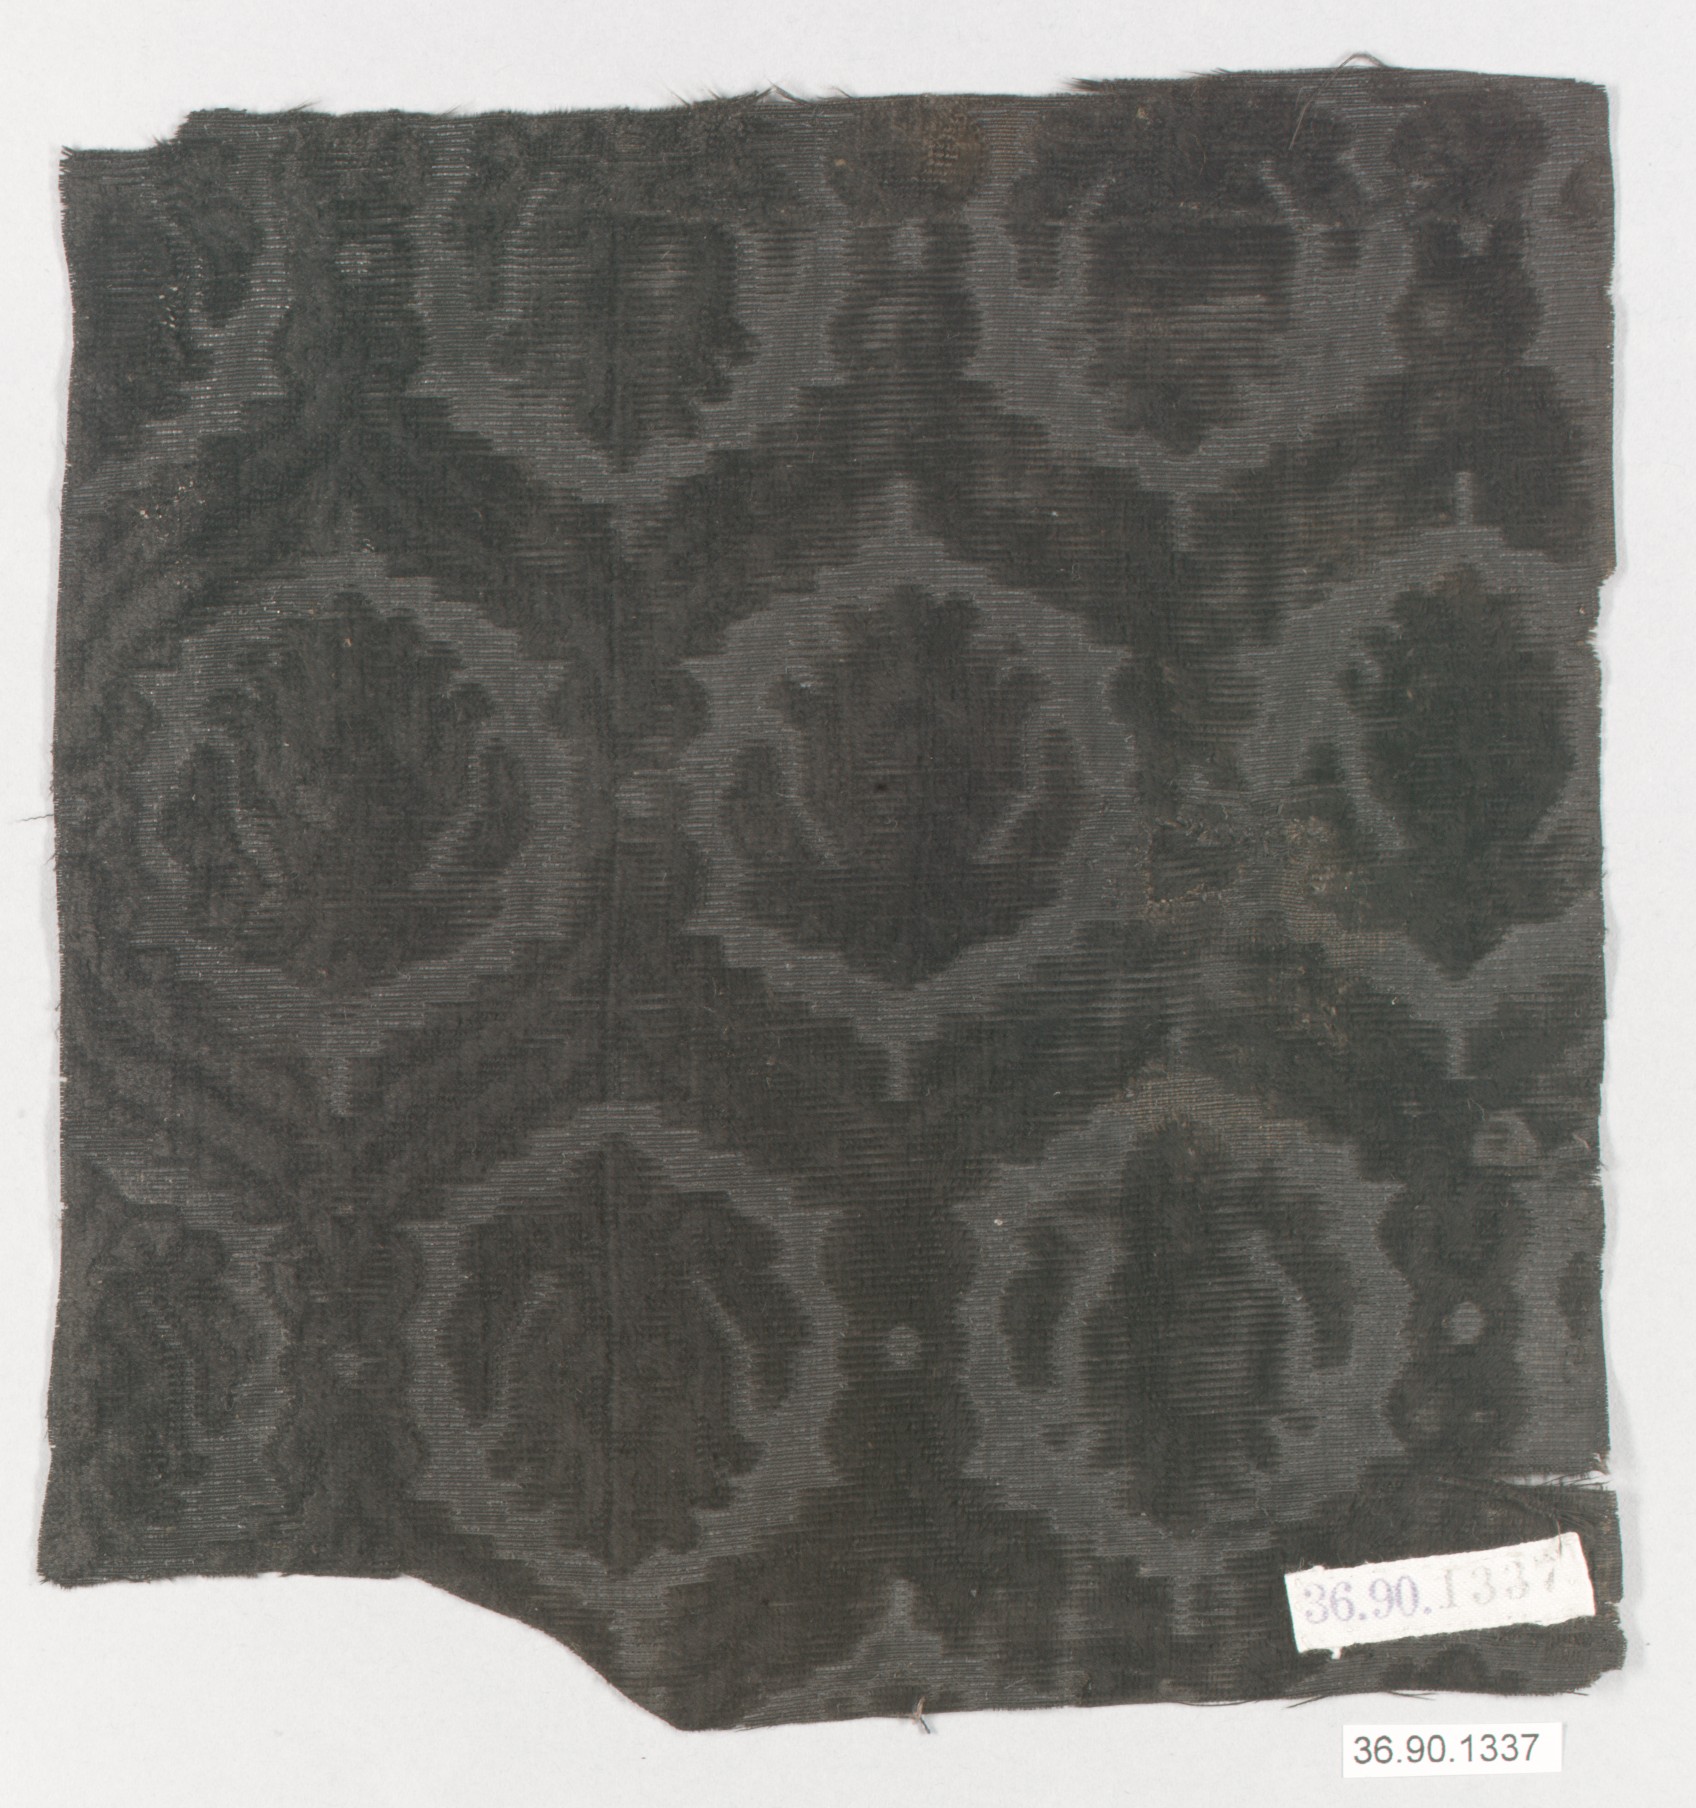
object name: piece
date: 1501-1700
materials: silk